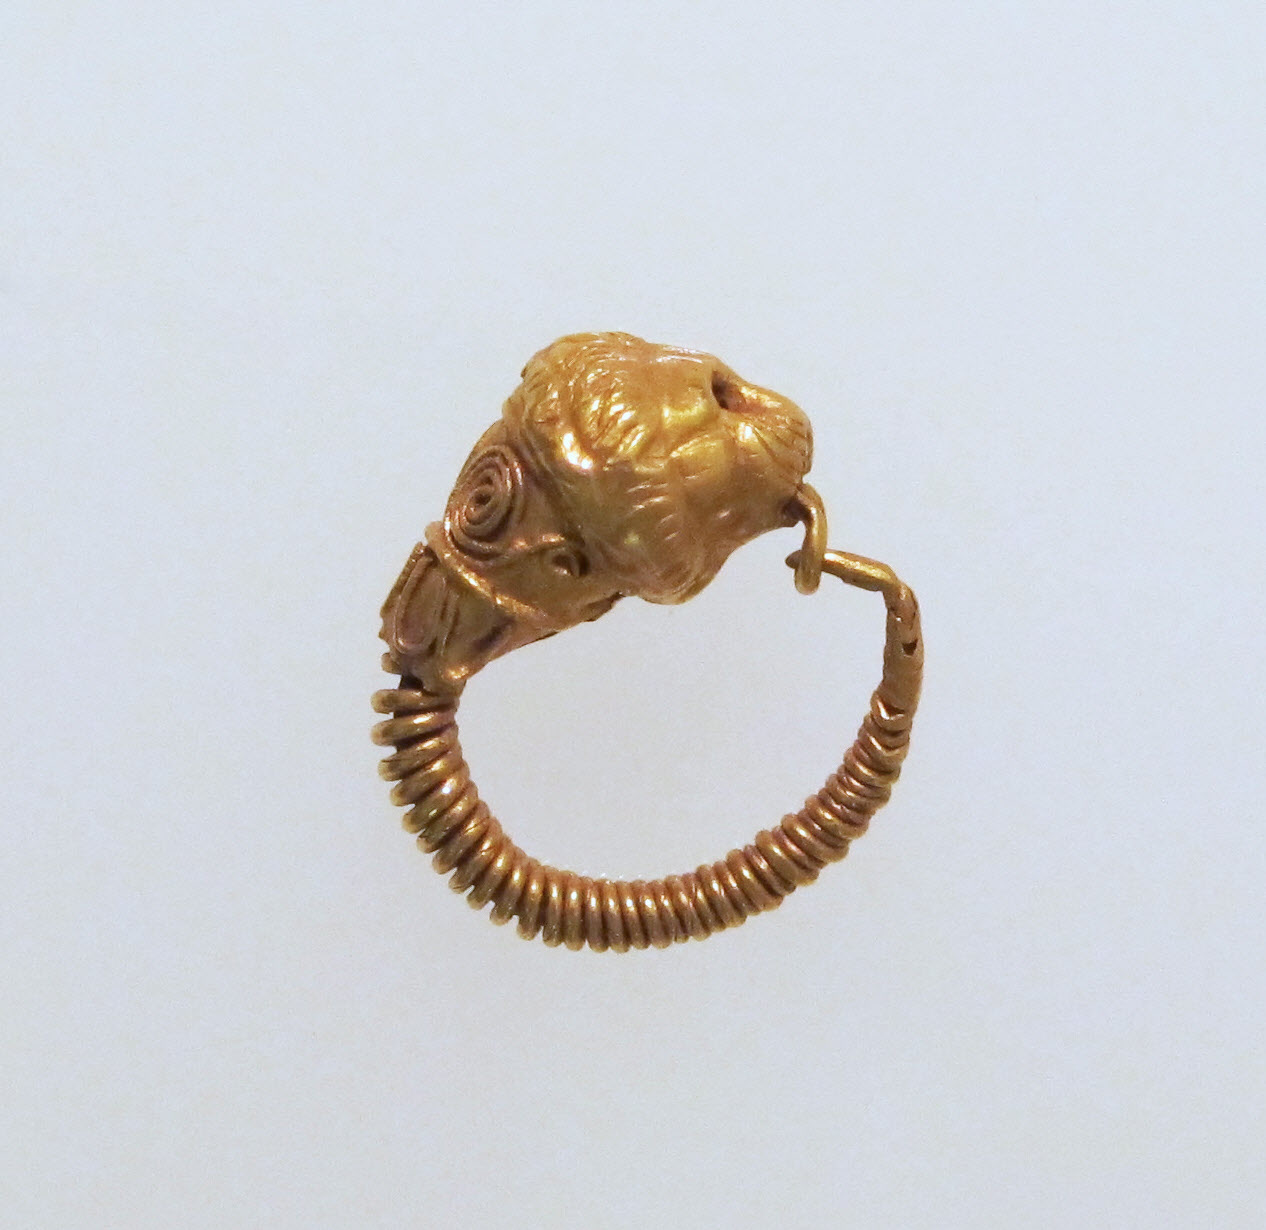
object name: earring with head of lion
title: Gold earring with head of a lion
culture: greek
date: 400-201 BCE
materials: gold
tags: lions